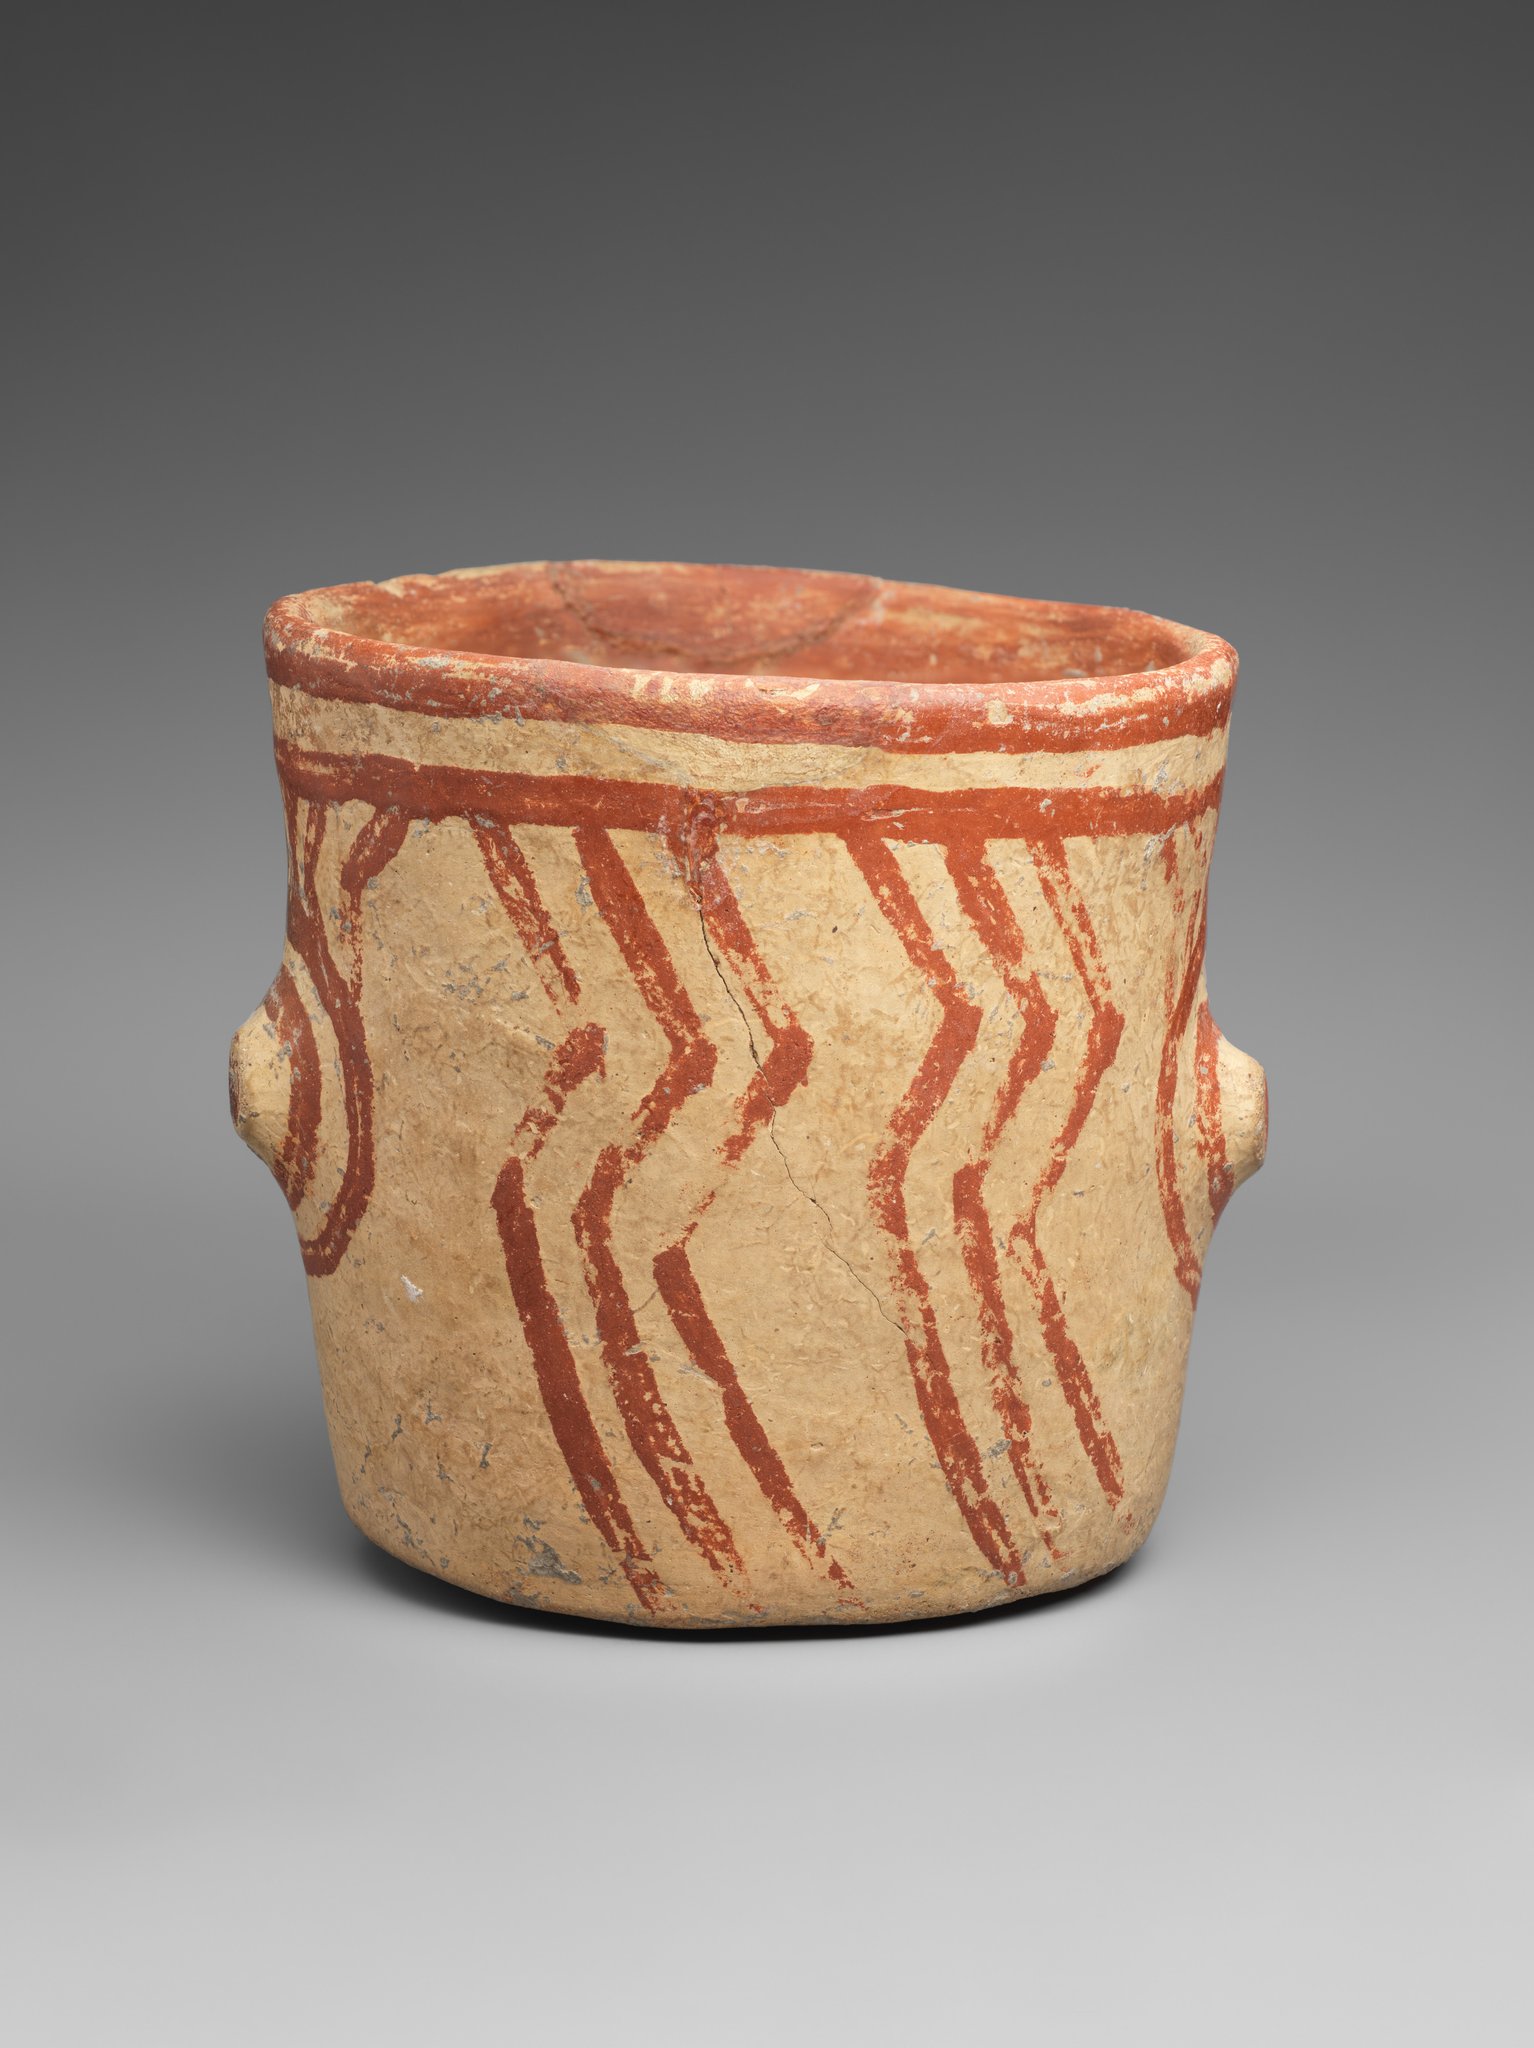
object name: vessel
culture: hacilar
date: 5600-5400 BCE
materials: ceramic, paint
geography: southwestern anatolia